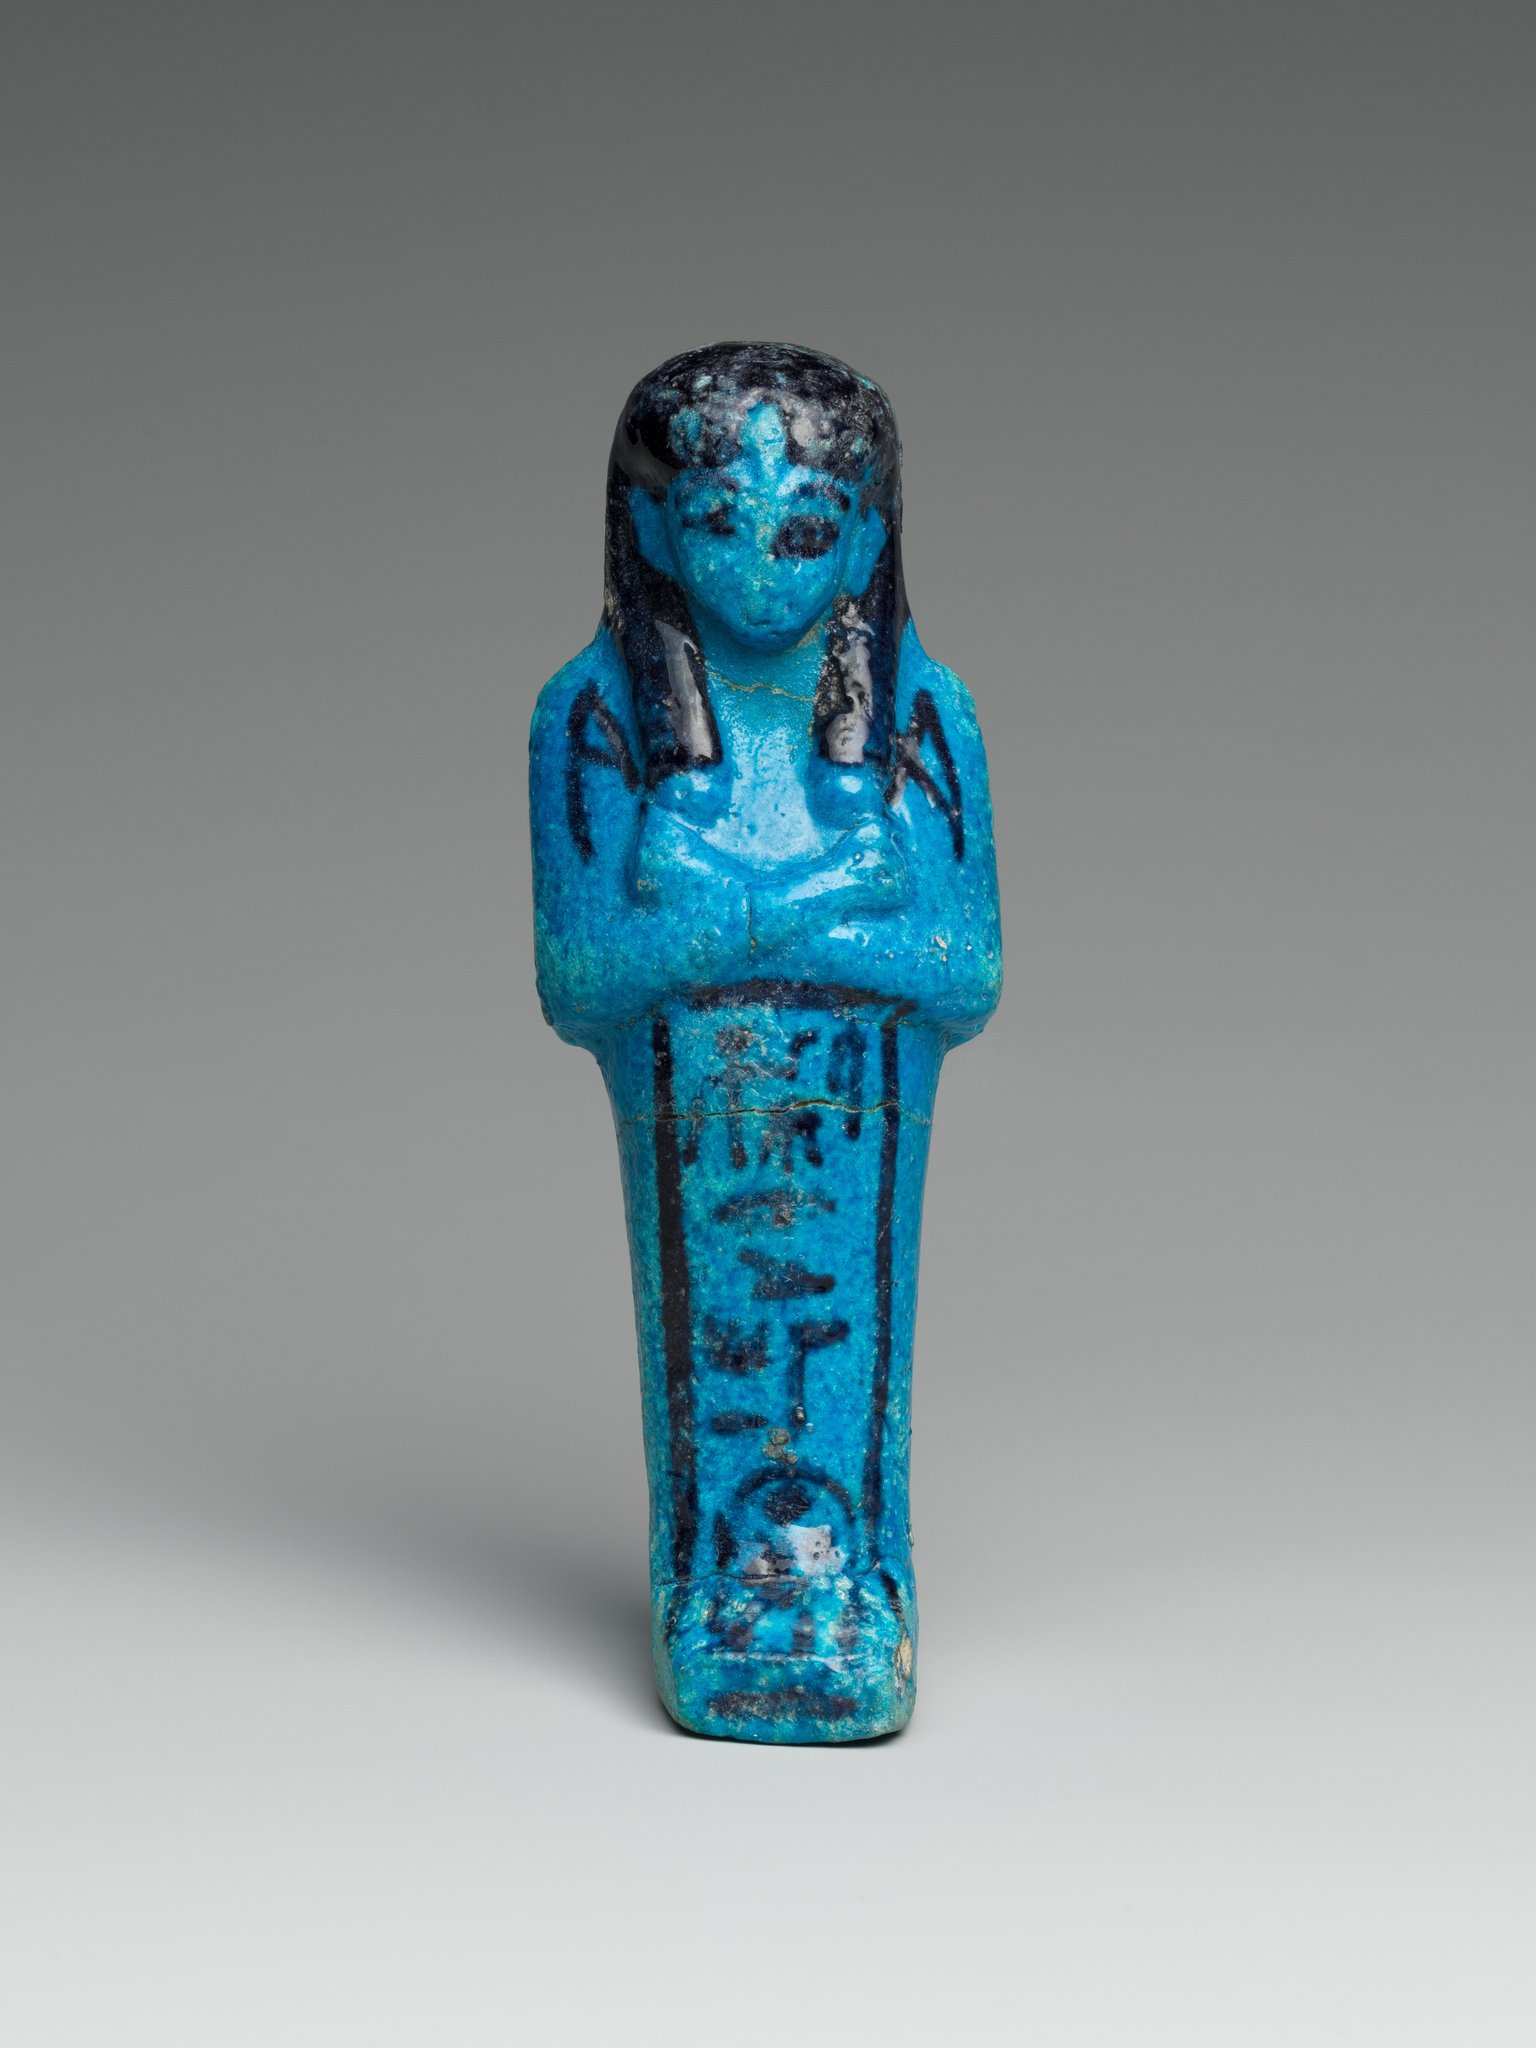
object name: shabti, god's wife maatkare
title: Shabti of the God's Wife Maatkare, daughter of Painedjem I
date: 1070-1032 BCE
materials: faience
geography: upper egypt, thebes